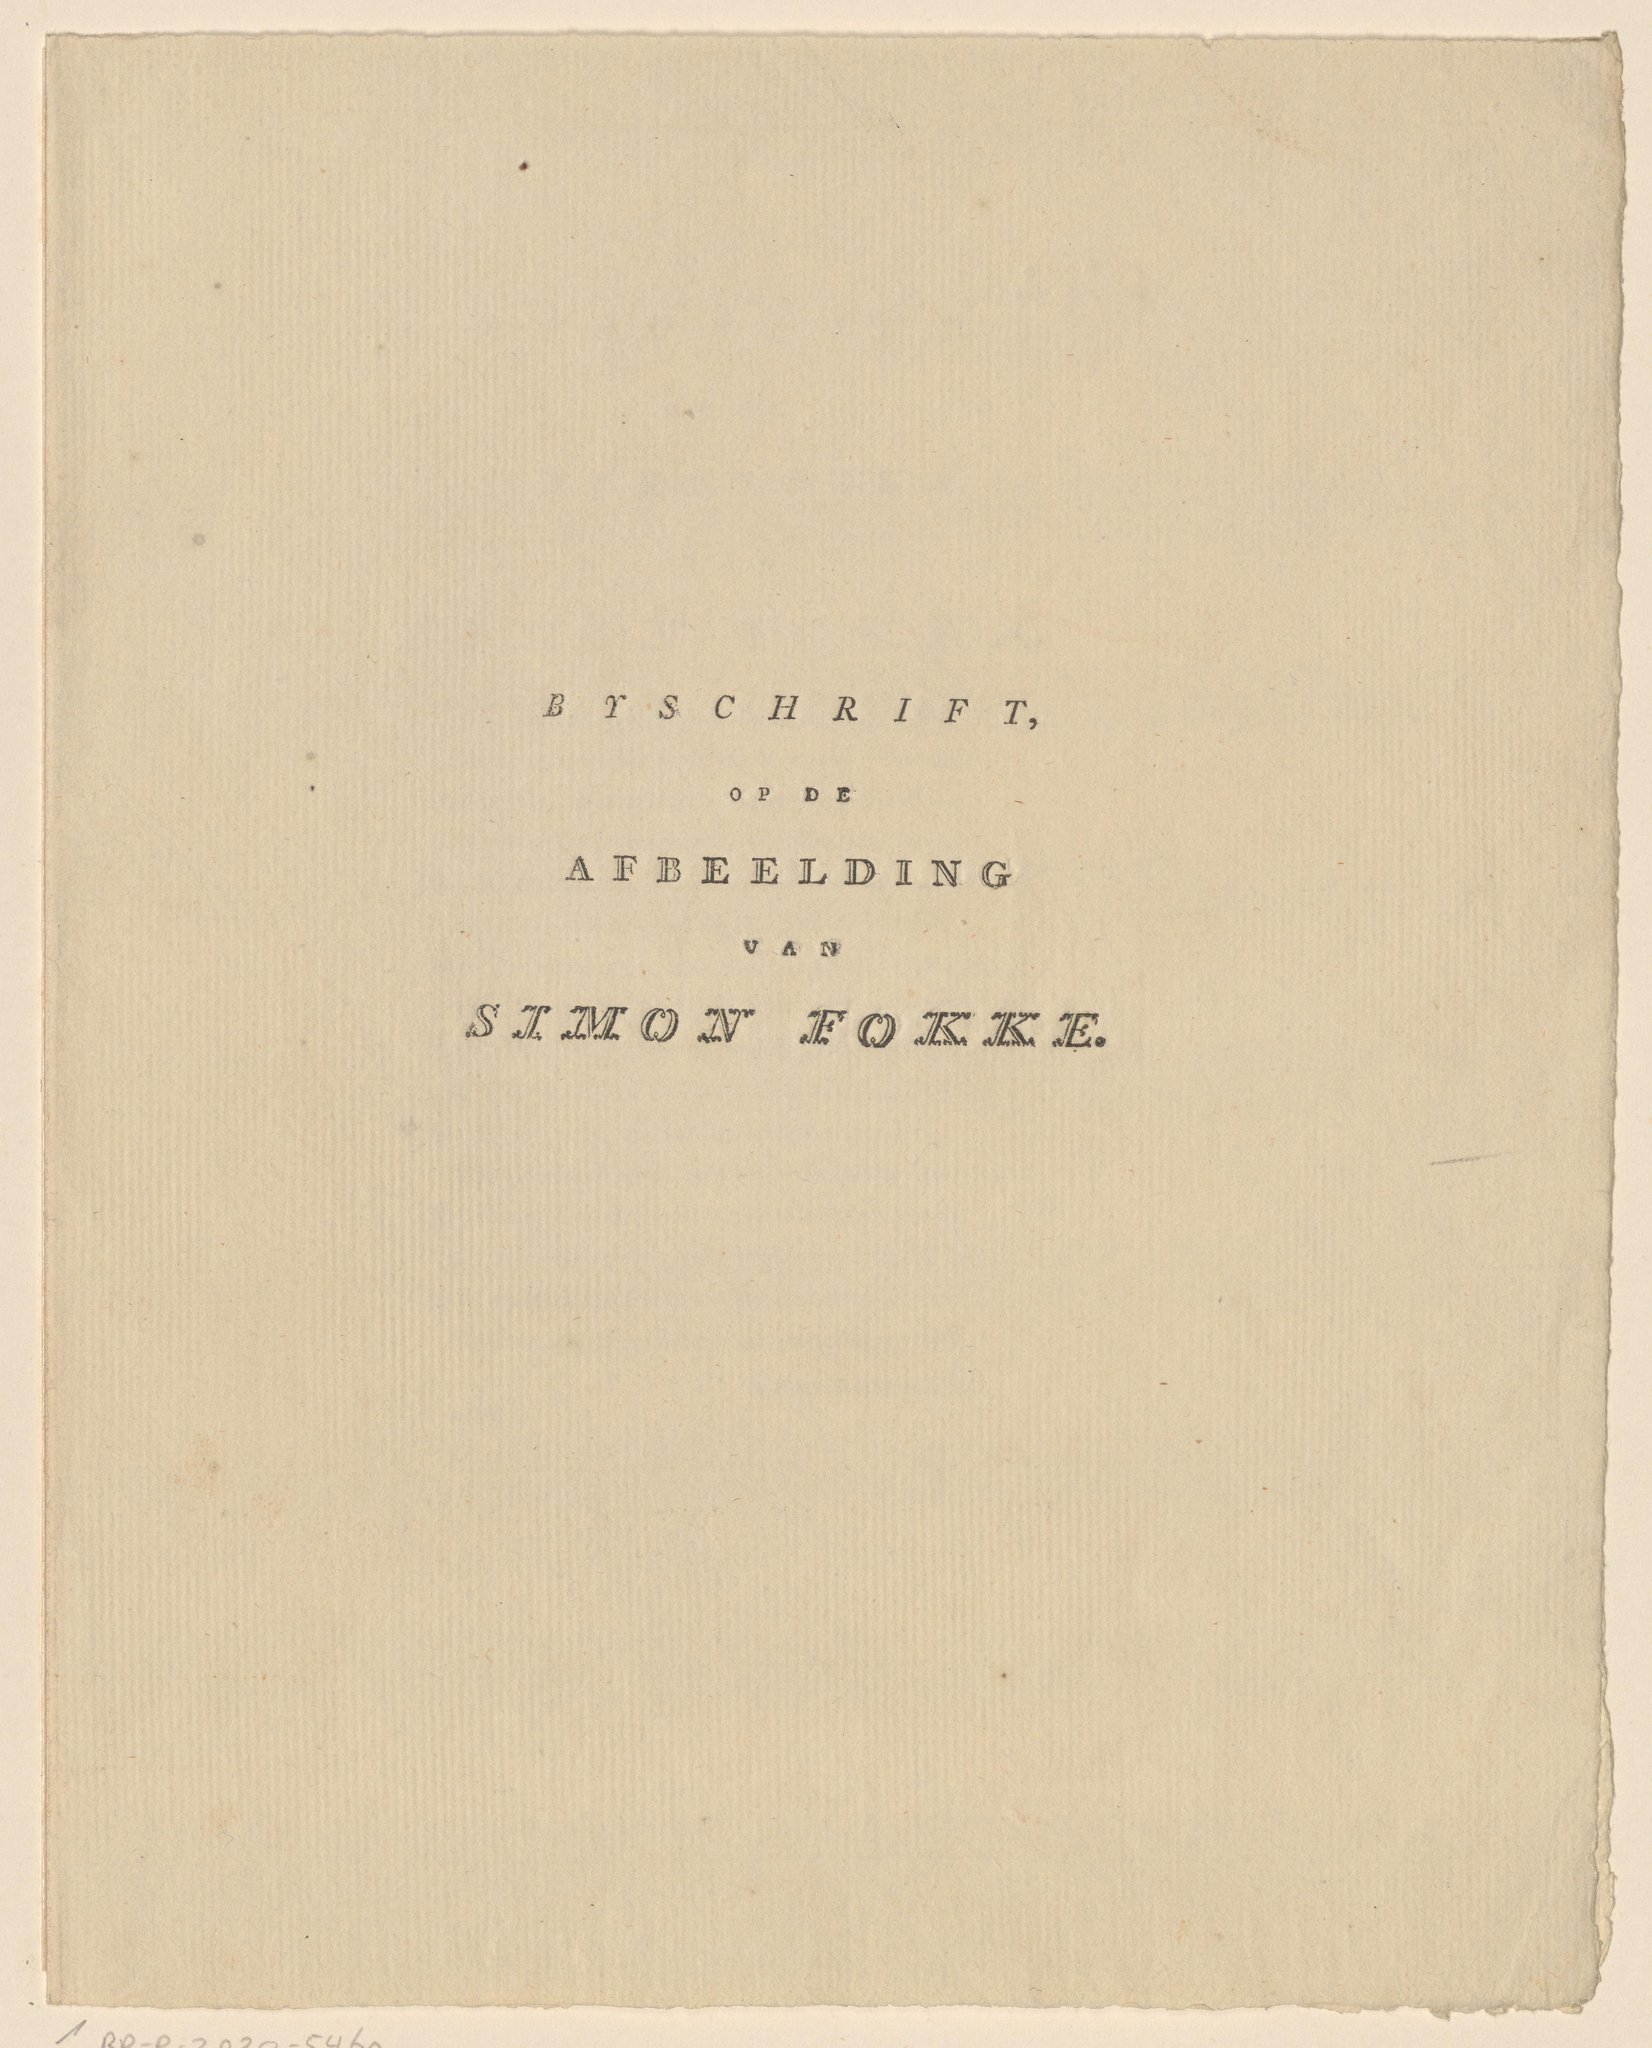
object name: text sheet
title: Bijschrift op de afbeelding van Simon Fokke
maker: arend fokke simonsz.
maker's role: publisher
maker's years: 1755-1812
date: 1781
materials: paper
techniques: letterpress printing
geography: amsterdam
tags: amsterdam, print maker, draughtsman, simon fokke, historical persons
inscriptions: date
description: Tekstblad van twee pagina's, met op de tweede pagina het gedicht. Mogelijk een bijschrift bij Simon Fokkes zelfportret.